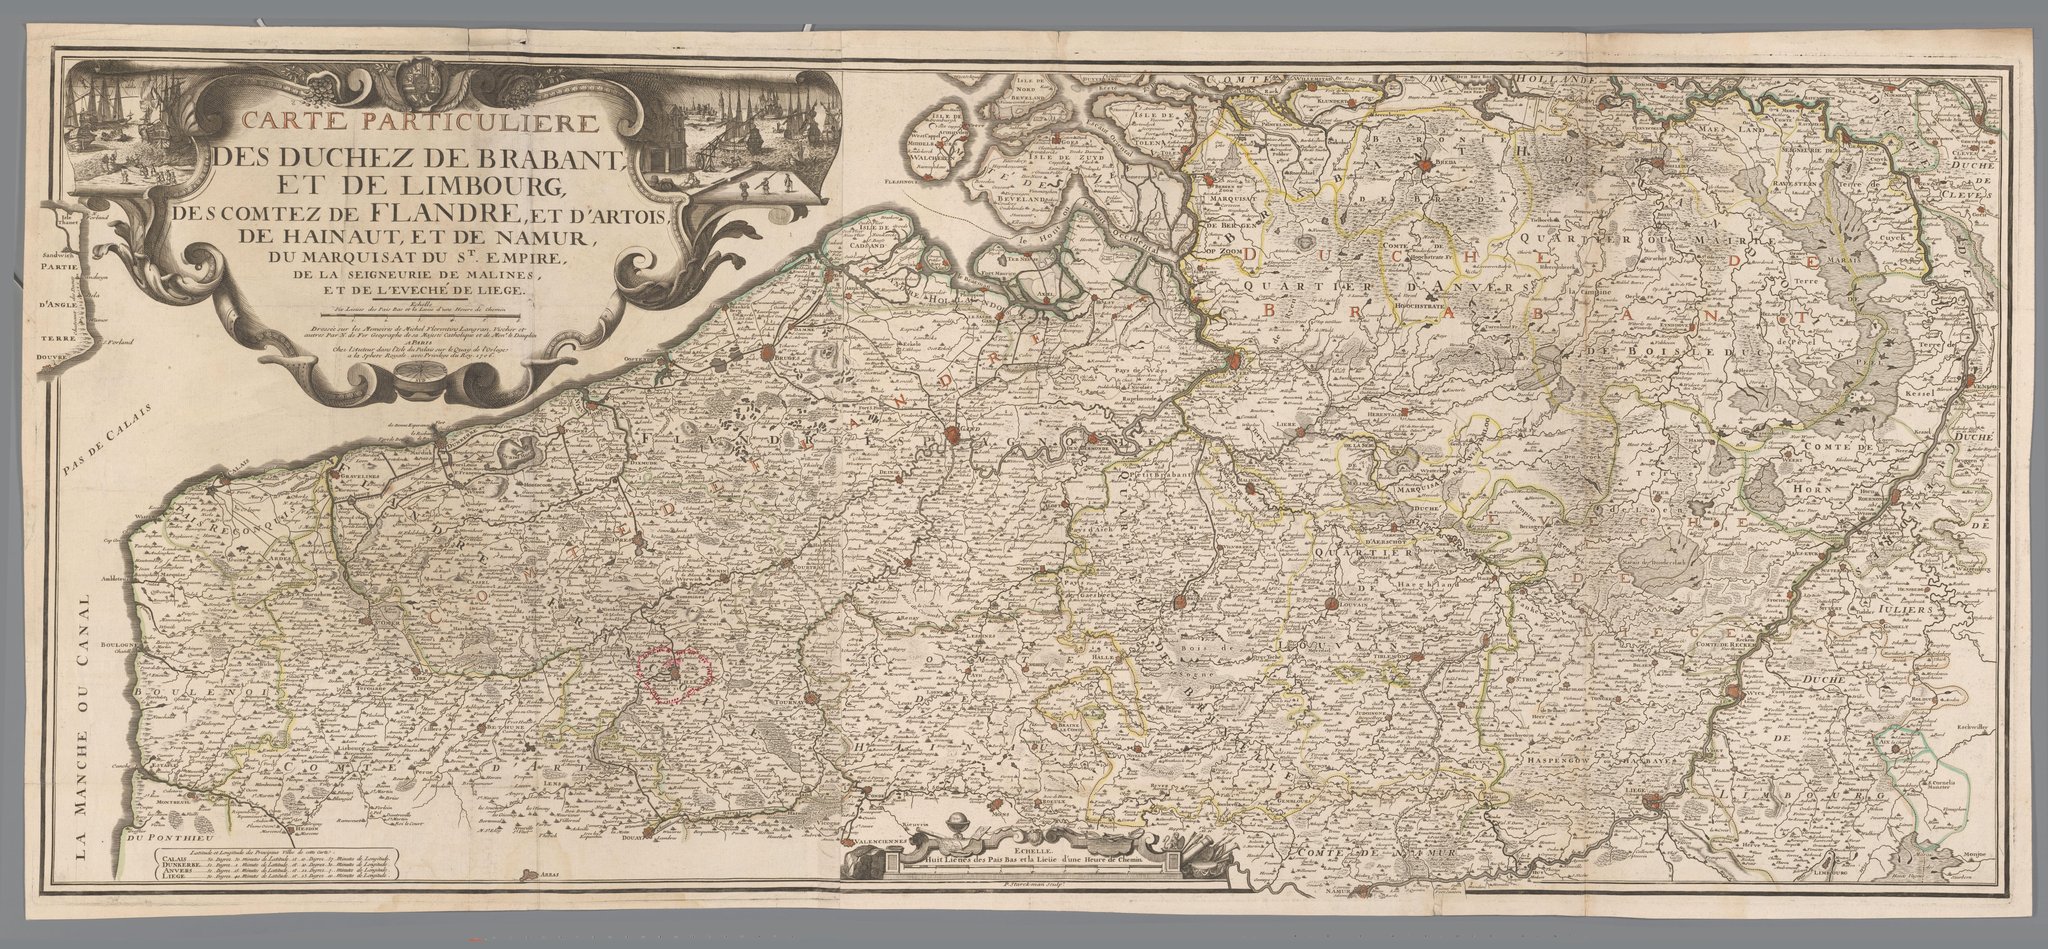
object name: print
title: Kaart van de hertogdommen Brabant en Limburg en van de graafschappen Vlaanderen, Artesië, Henegouwen en Namen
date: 1706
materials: paper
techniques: engraving, etching, hand coloring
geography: paris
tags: maps of separate countries or regions, brabant, henegouwen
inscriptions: date